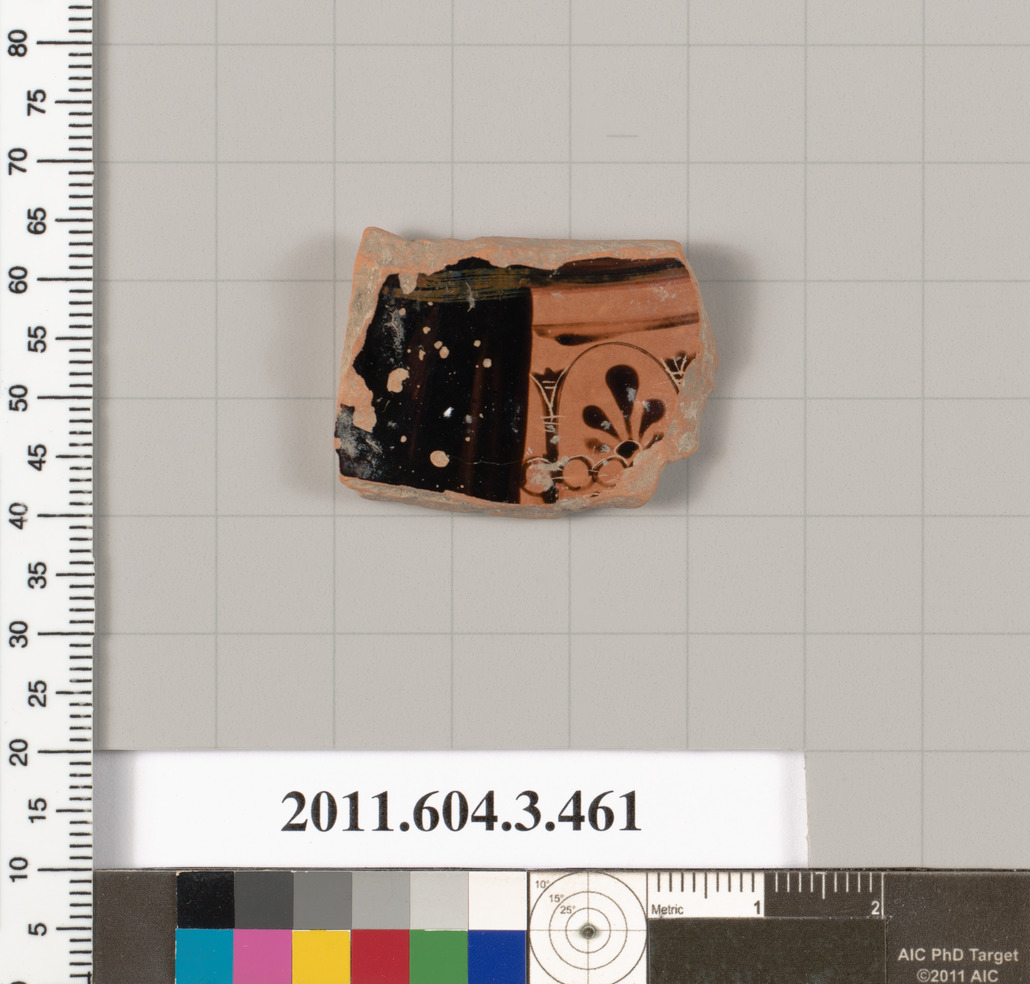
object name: amphora fragment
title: Terracotta fragment of an amphora (jar)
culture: greek, attic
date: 534-468 BCE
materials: terracotta